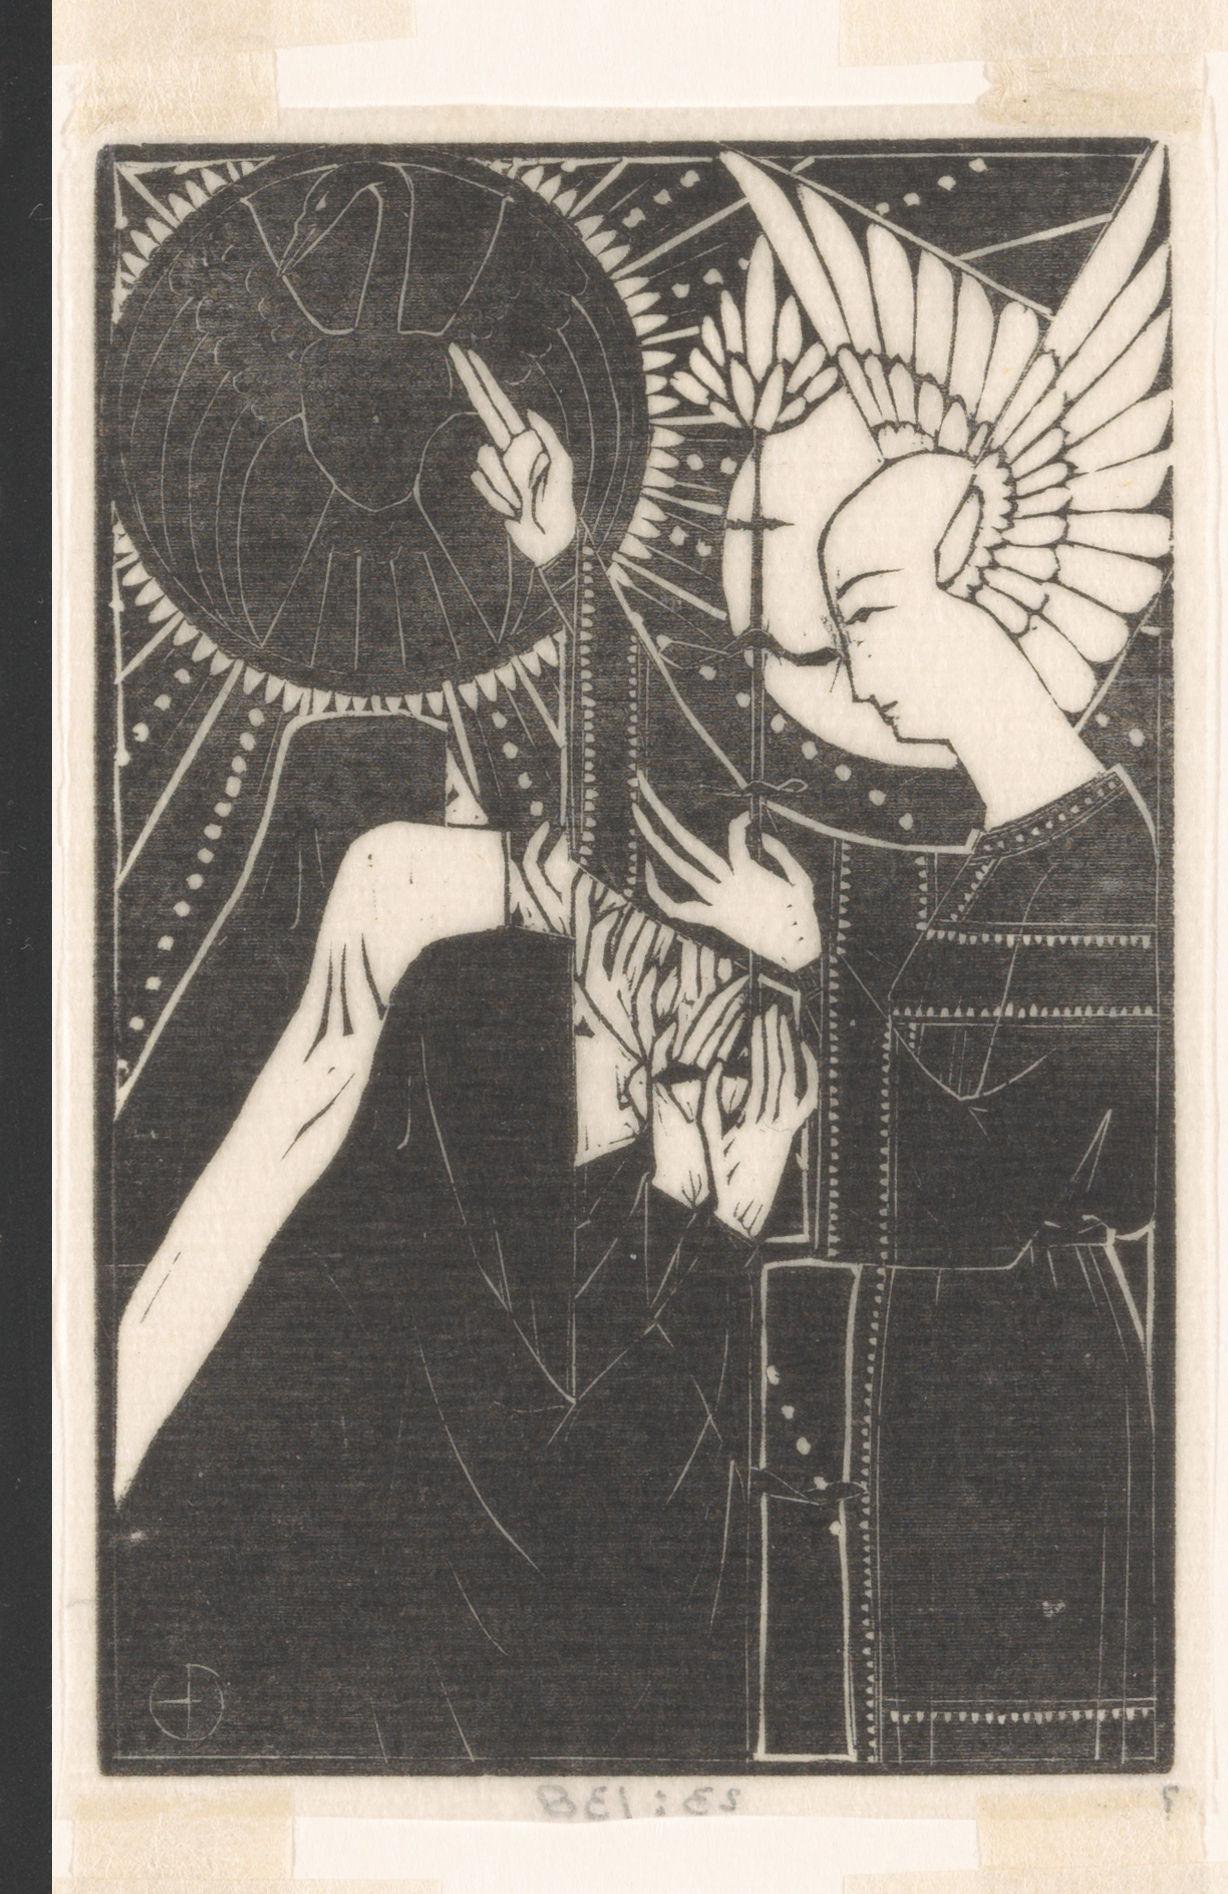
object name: illustration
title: Drie knielende figuren voor gevleugelde man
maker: mathieu lauweriks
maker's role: designer, draughtsman, print maker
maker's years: 1864-1932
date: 1895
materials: paper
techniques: woodcut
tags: kneeling figure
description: Rechts staat een man met vleugels in plaats van oren. Hij wendt zich tot de drie figuren die voor hem knielen. In zijn linkerhand houdt hij een bloem; met rechts wijst hij naar de zon waarin een vogel met gespreide vleugels te zien is.